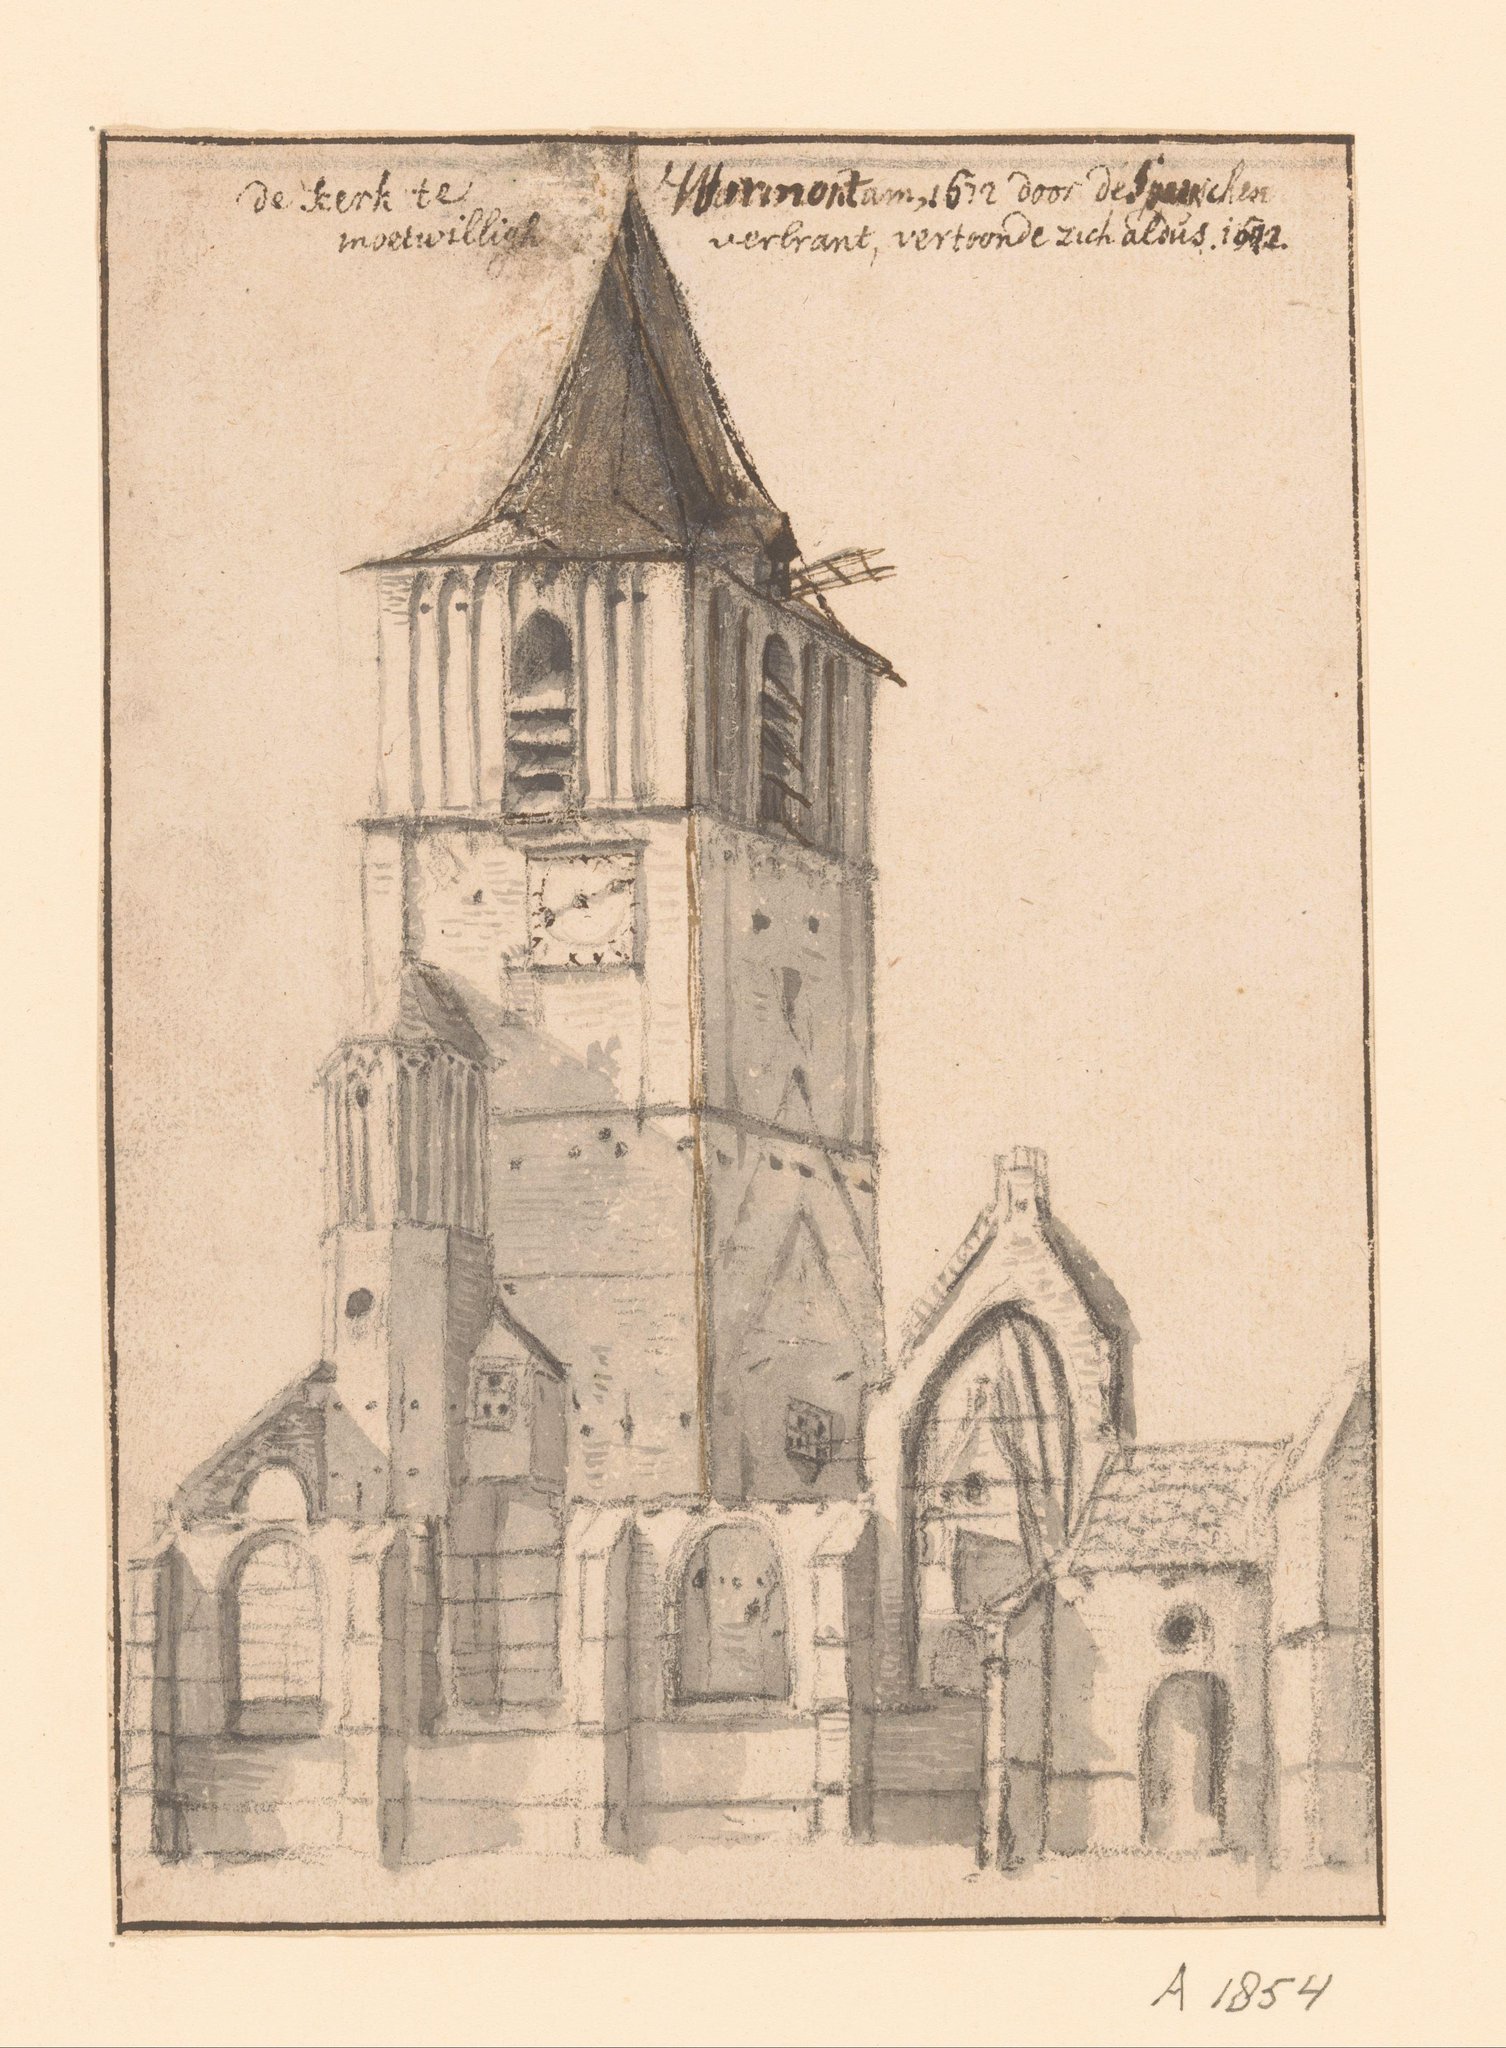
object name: drawing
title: Gezicht op de toren van de kerk te Warmond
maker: Anonymous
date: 1700-1750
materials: chalk, ink, paper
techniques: brush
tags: church (exterior), landscape with ruins, warmond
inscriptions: collector's mark: Lugt 2228